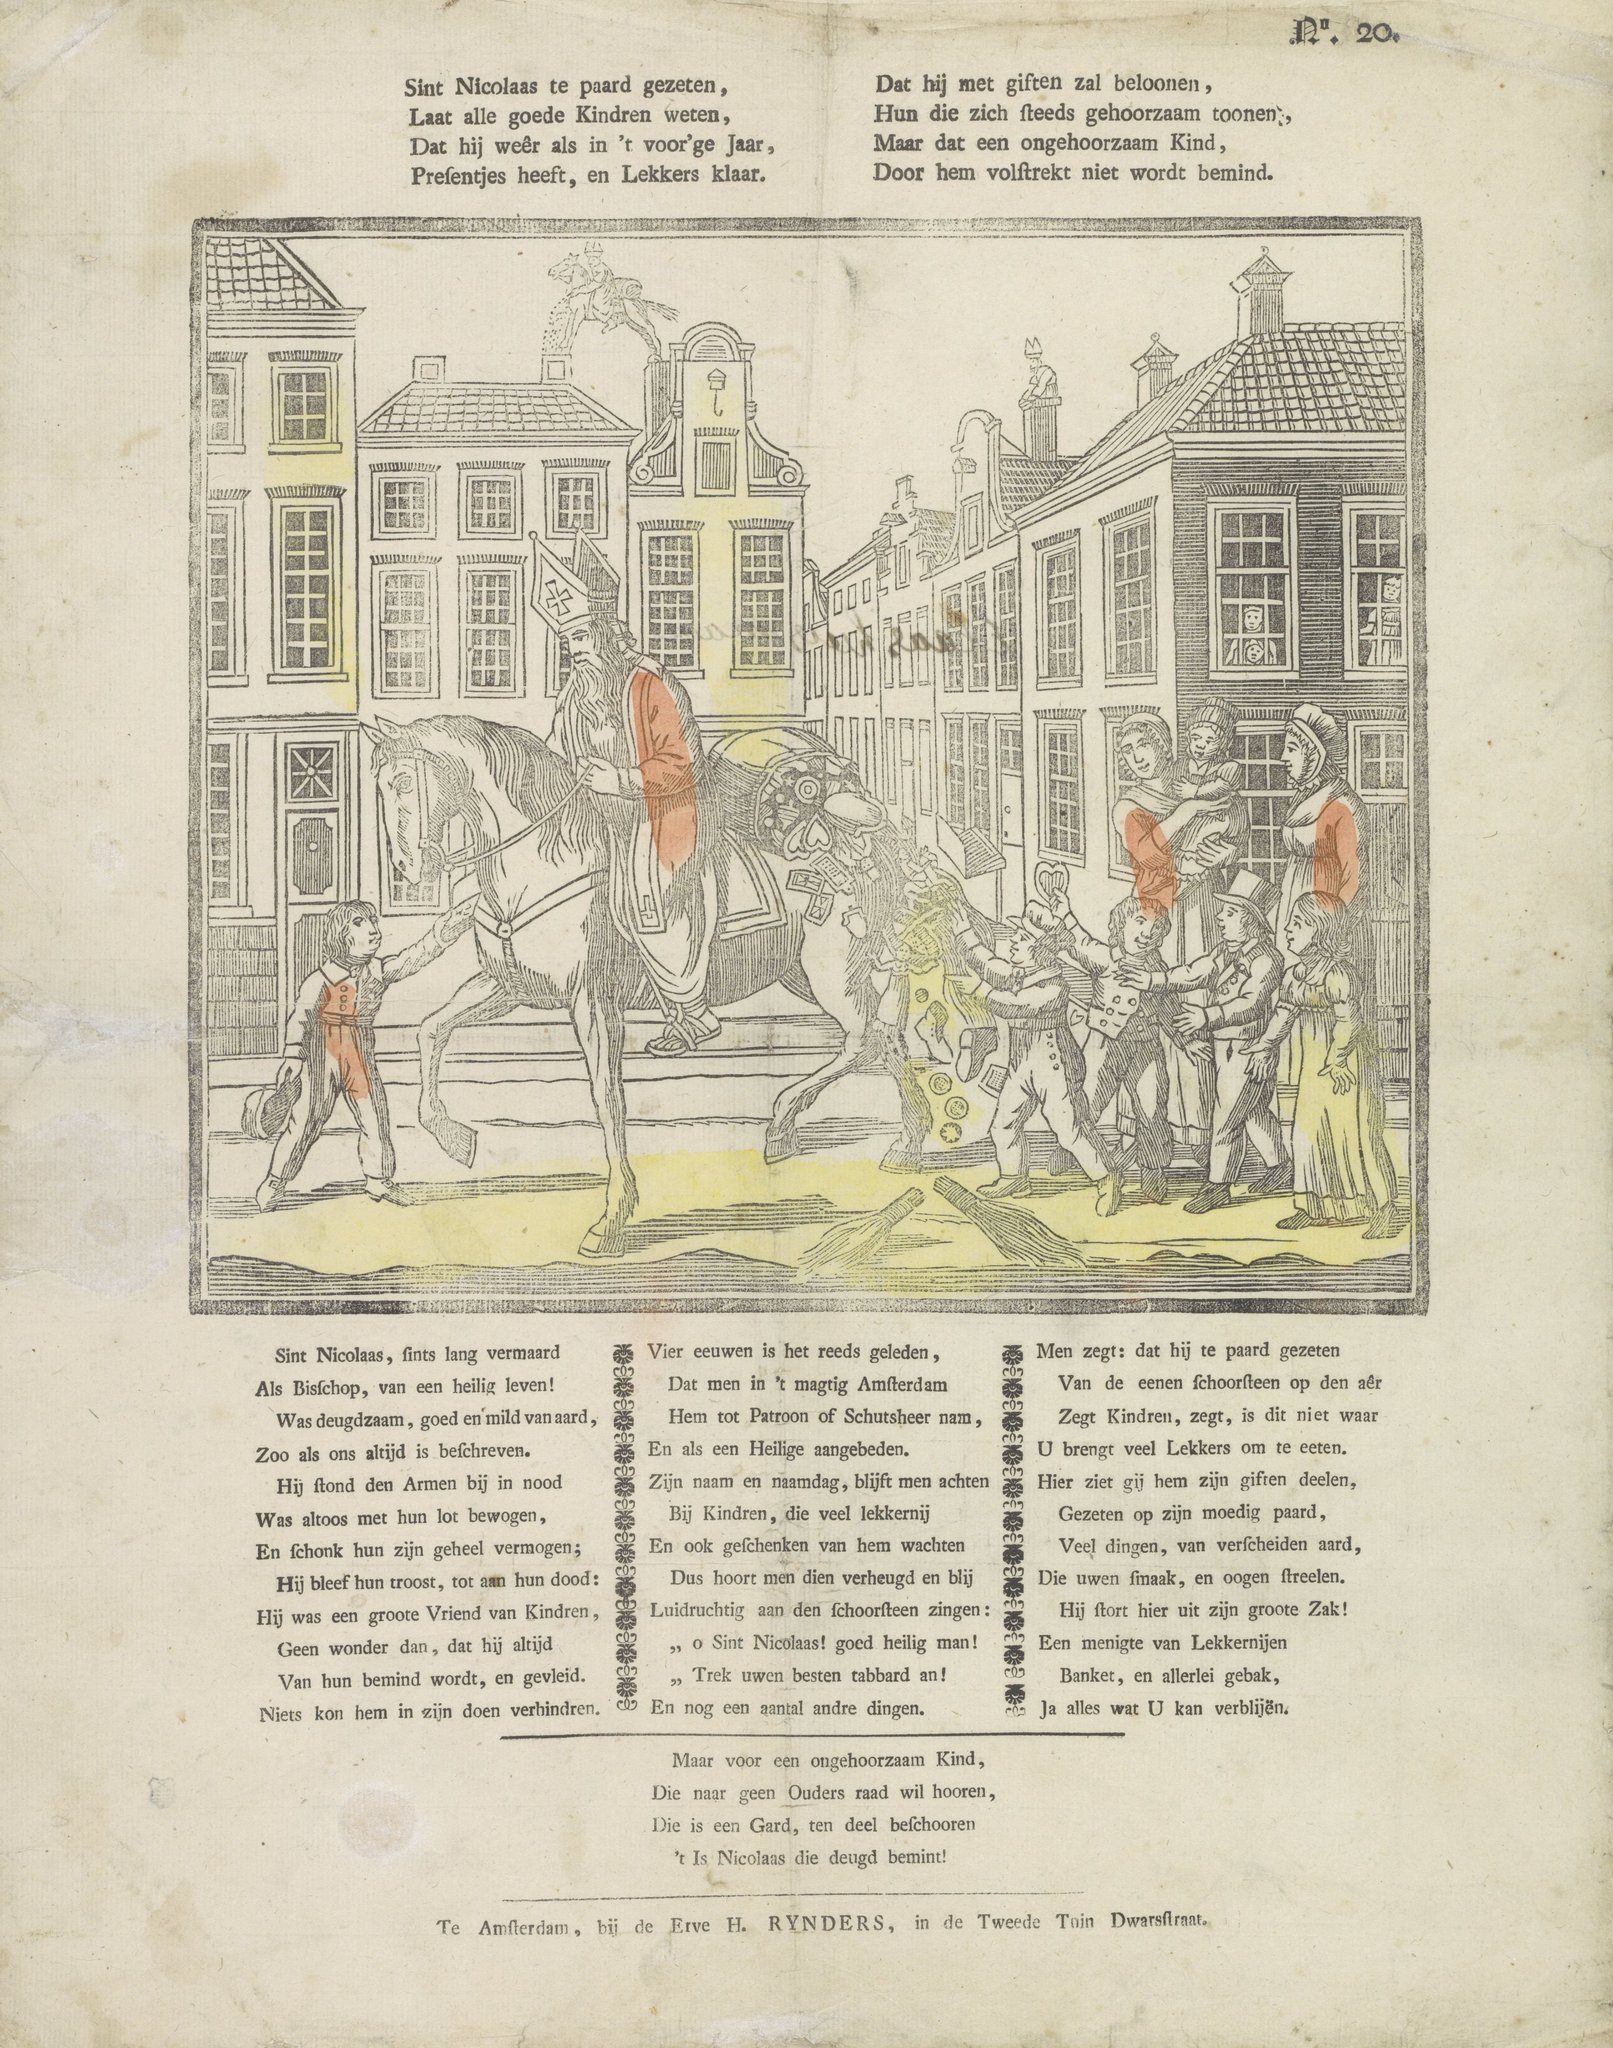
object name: print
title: Sint Nicolaas te paard gezeten, / Laat alle goede kindren weten [(...)]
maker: Anonymous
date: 1831-1854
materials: paper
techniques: colour, letterpress printing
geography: amsterdam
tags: the bishop nicholas of myra (or bari); possible attributes: anchor, boat, three golden balls (on a book), three purses, three children in a tub, three maidens, festivities on st. nicholas (eve) (december 5)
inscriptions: collector's mark: Lugt 2760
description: Blad met een grote voorstelling van Sint Nicolaas te paard, die snoep en speelgoed uitdeelt aan kinderen op straat. Op de achtergrond Sint Nicolaas te paard op het dak. In de ondermarge een vers in vier kolommen. Genummerd rechtsboven: No. 20.